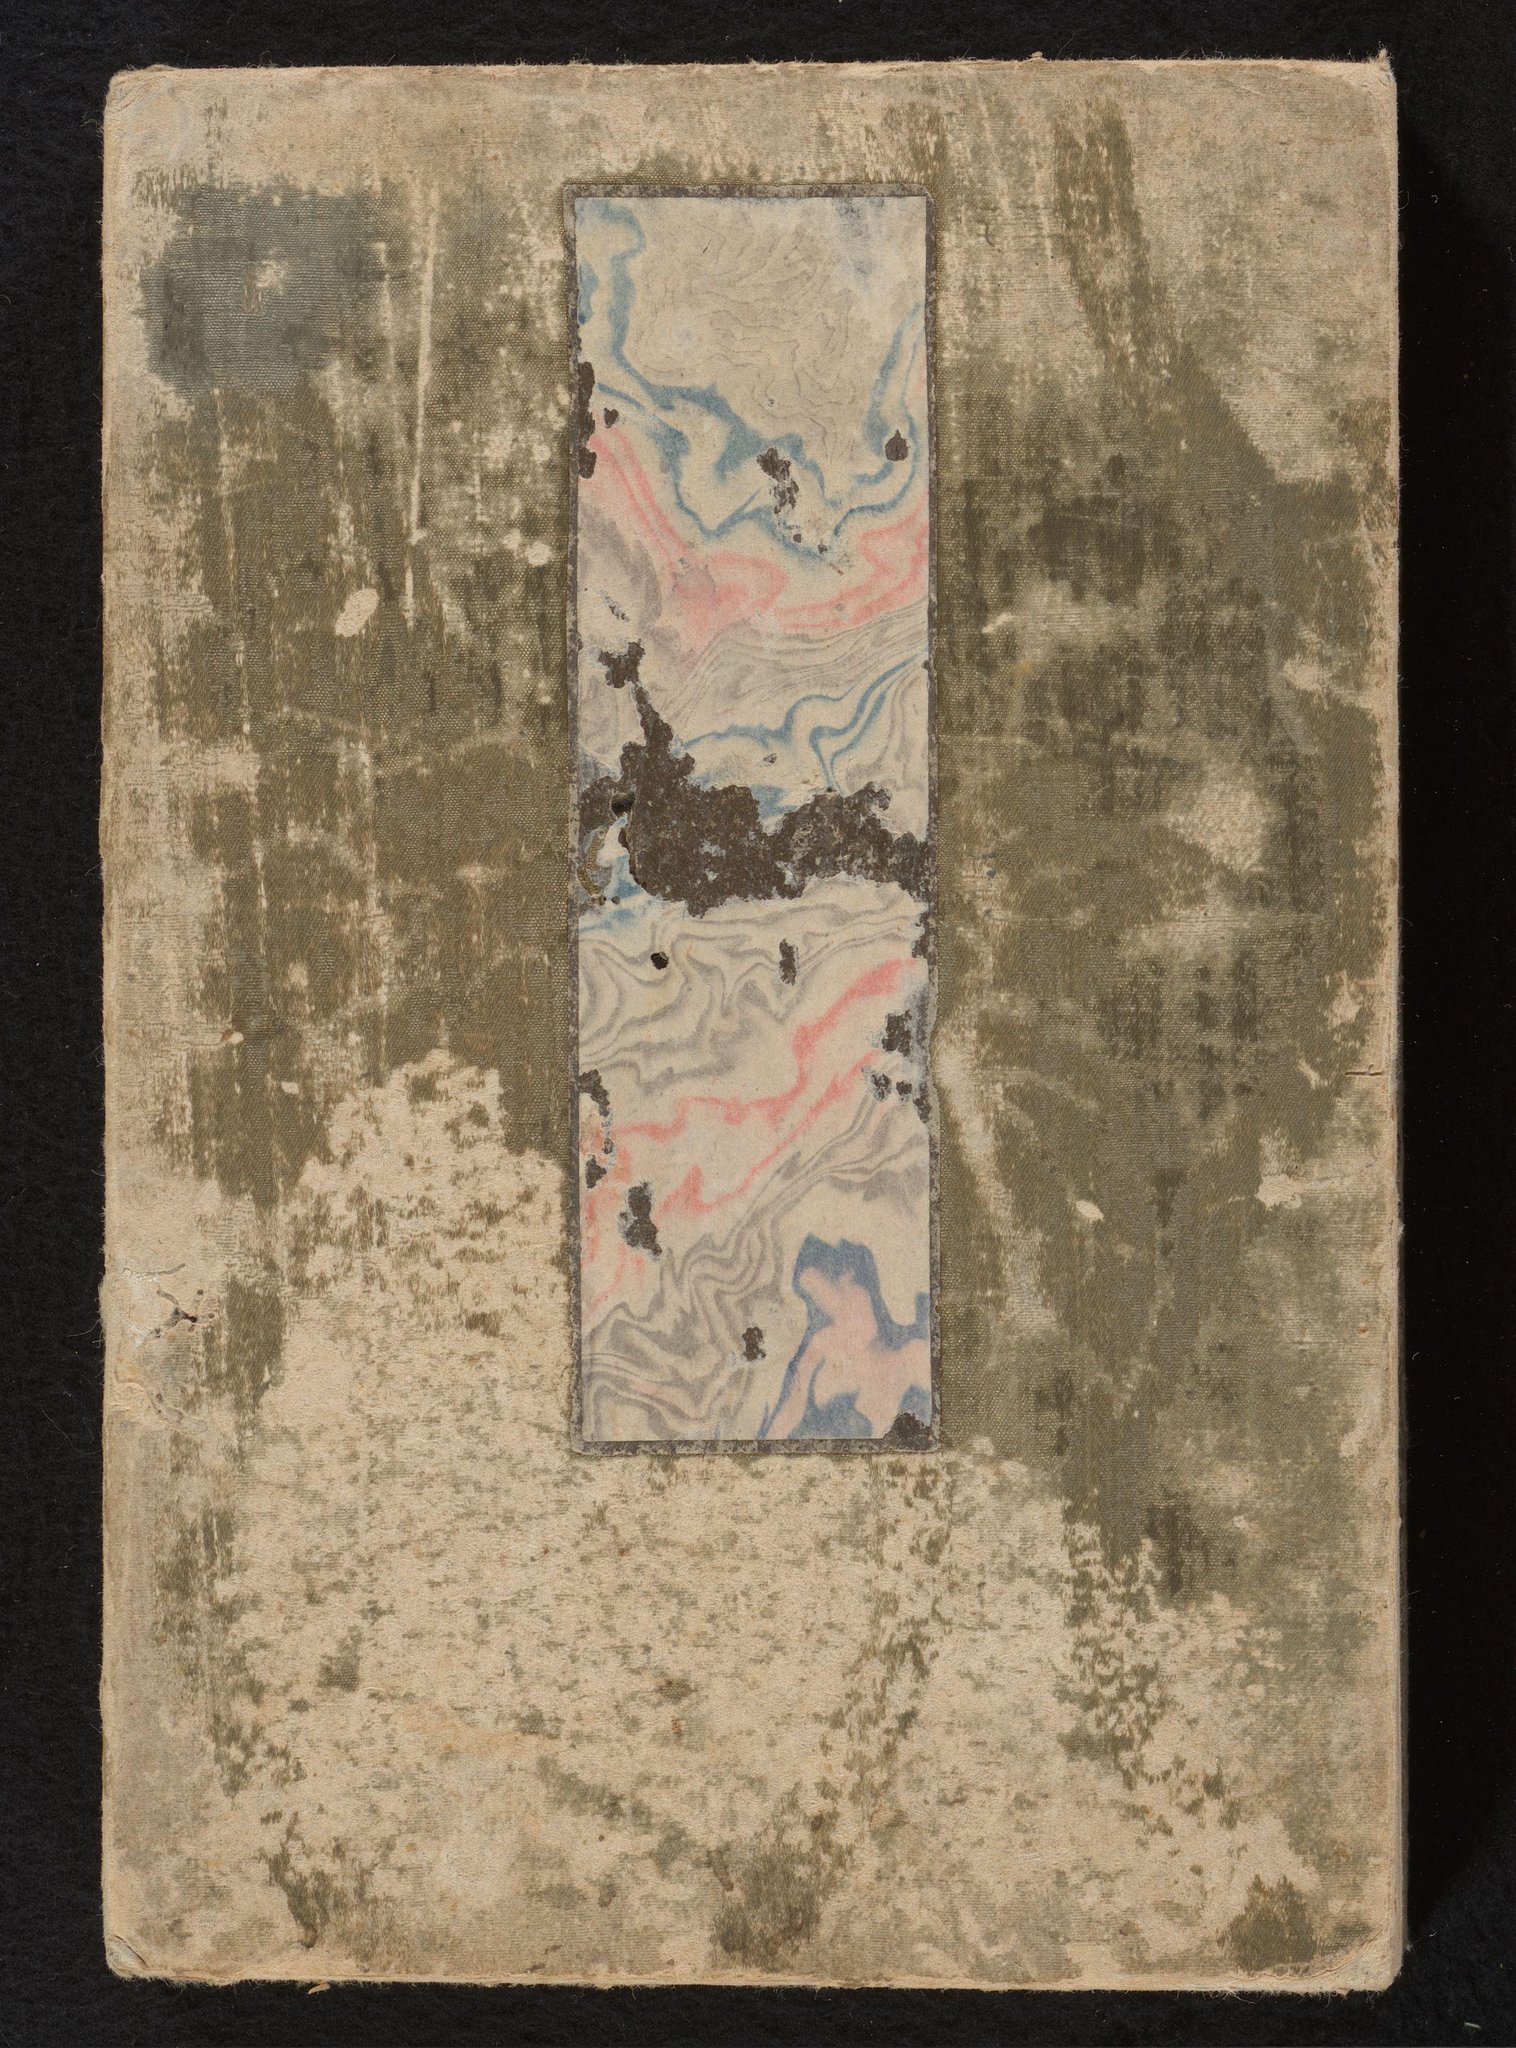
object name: book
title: Surimono album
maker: matsukawa hanzan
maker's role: print maker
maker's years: 1805-1882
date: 1860-1865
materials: gold powder, paper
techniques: blind stamped, brocade, woodcut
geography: japan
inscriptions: collector's mark: Lugt 2228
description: Een surimono is een luxe uitgevoerde prent waarop beeld met één of meerdere gedichten gecombineerd is. Bij het drukken van een surimono werd vaak gebruik gemaakt van dikker papier, blinddruk en metaal pigmenten, zoals koper- en zilverpoeder. De prenten werden vaak in opdracht van dichters gemaakt en als exclusief geschenk aan vrienden en relaties gegeven.